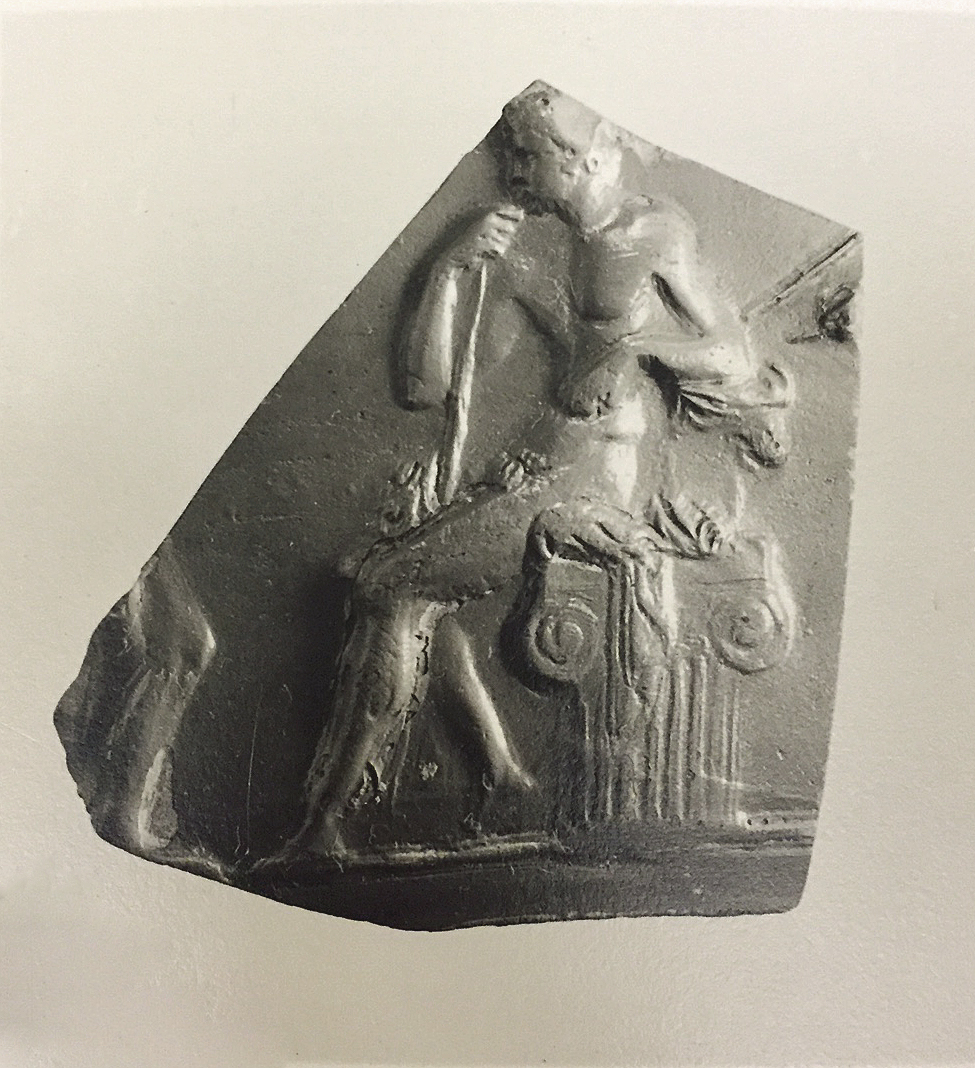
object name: vase fragment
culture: roman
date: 31 BCE-14 CE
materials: terracotta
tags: men